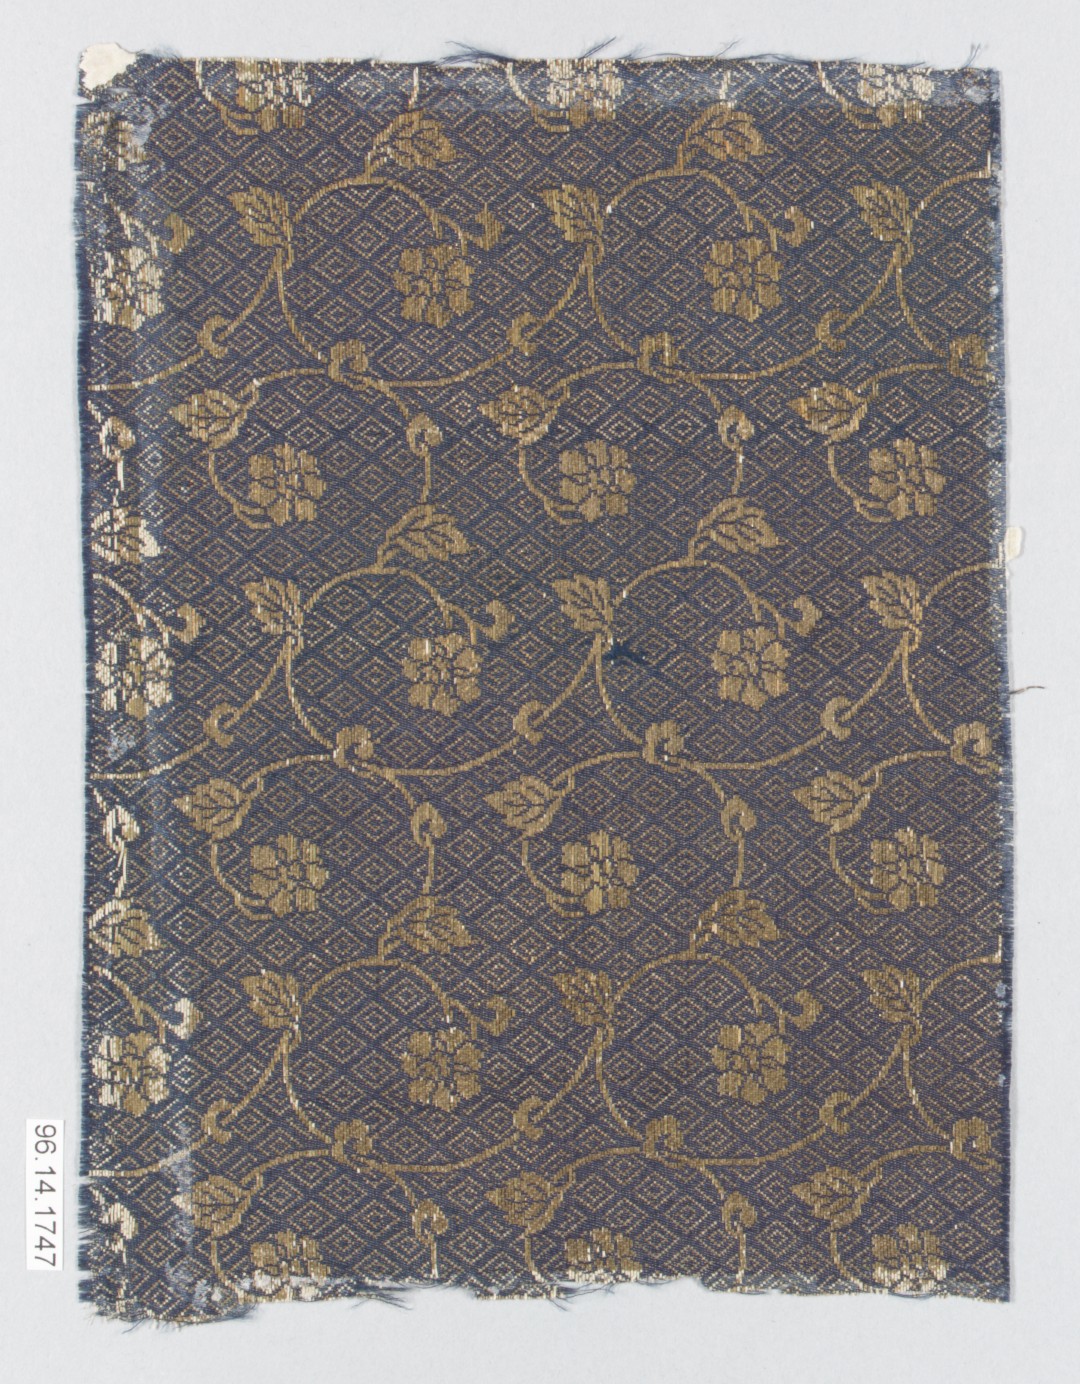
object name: piece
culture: japanese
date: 1601-1700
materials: silk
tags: leaves